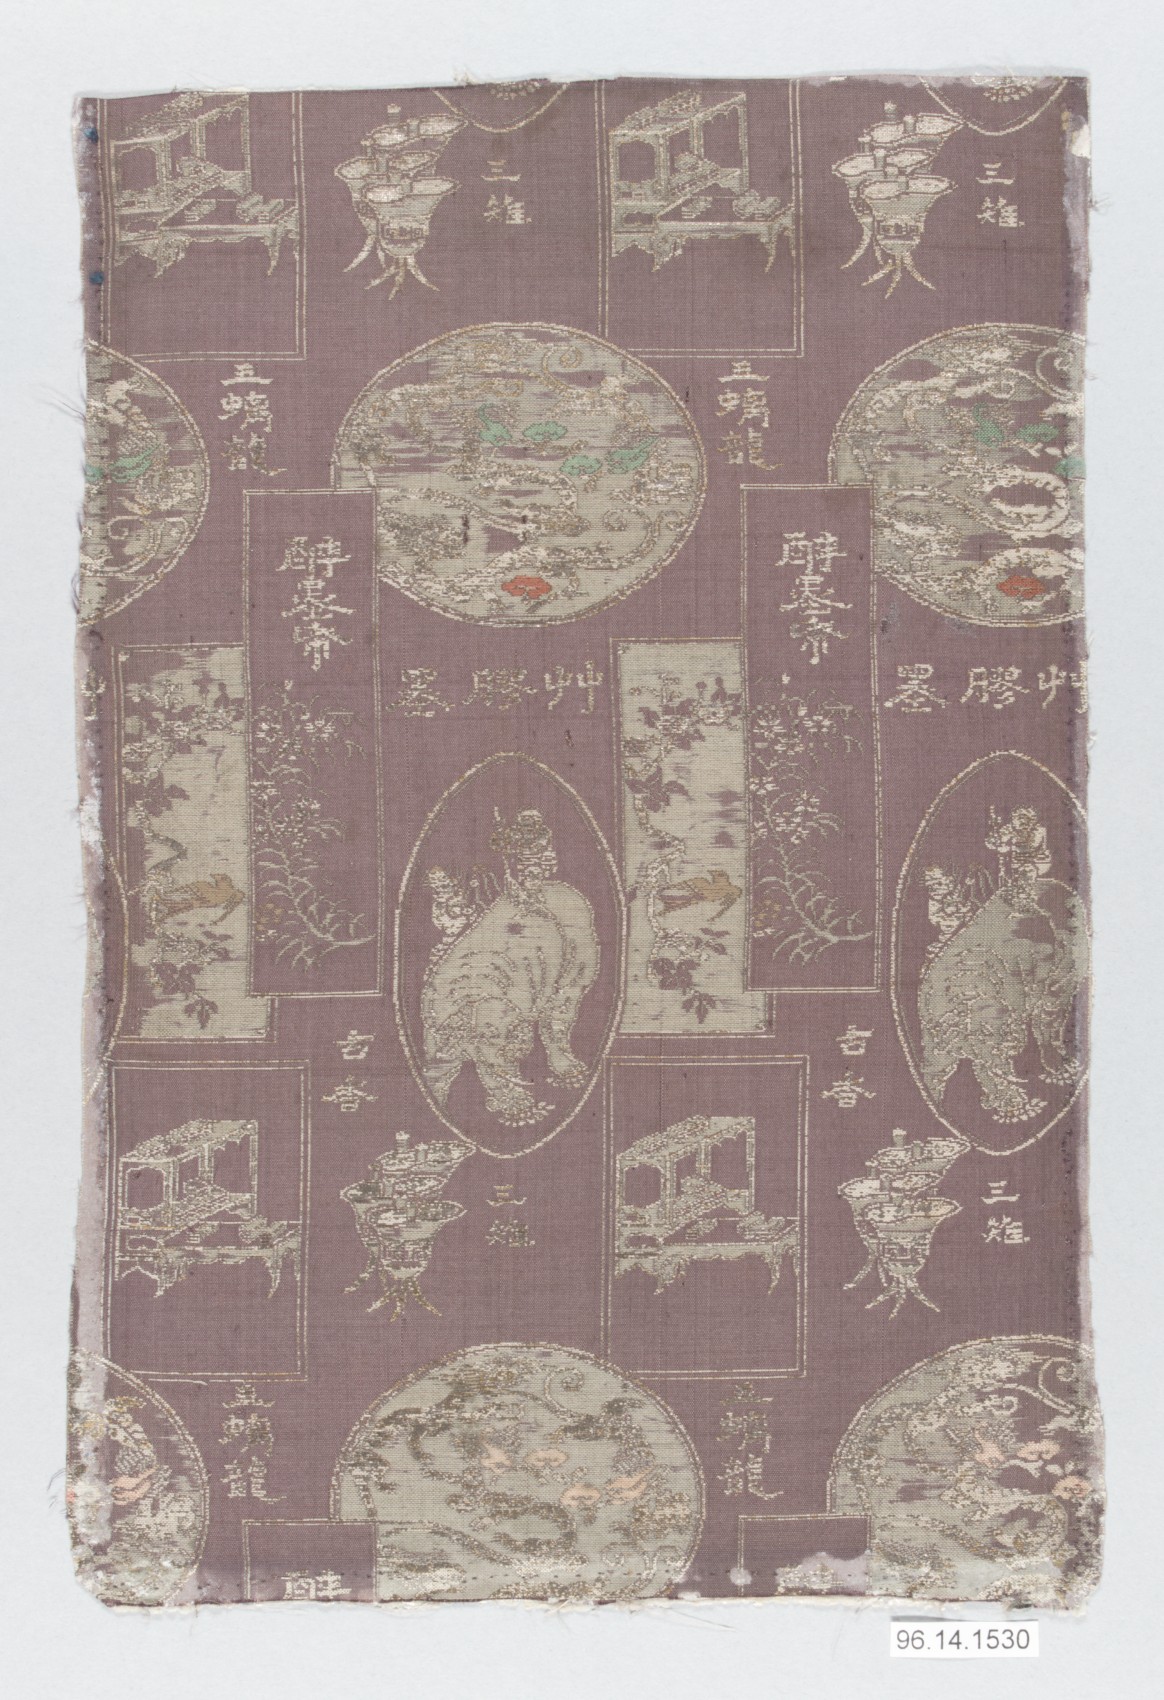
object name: piece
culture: japanese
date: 1701-1900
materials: silk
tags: dragons,elephants